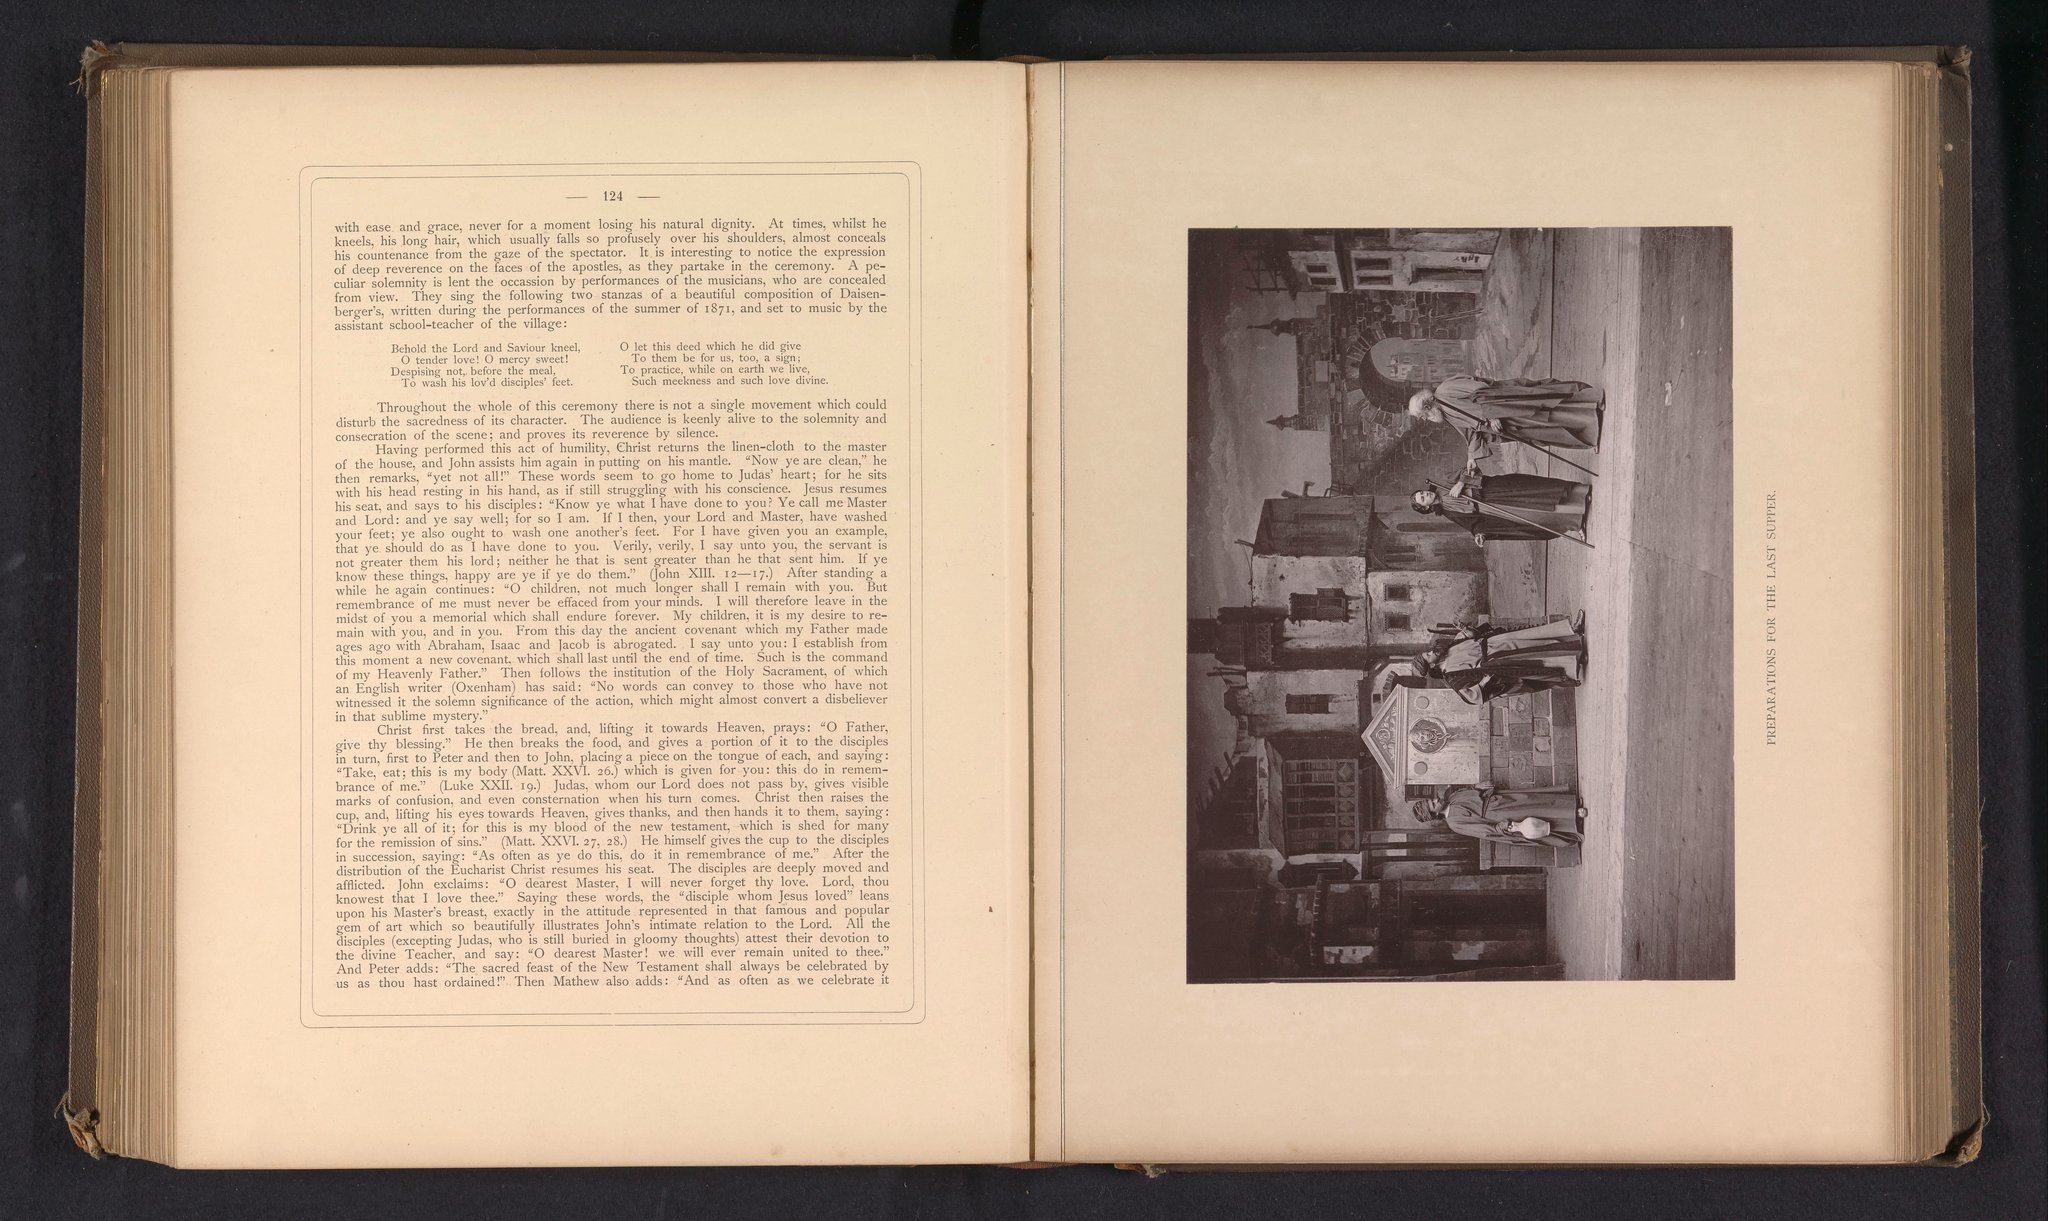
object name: photomechanical print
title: Preparations for the last supper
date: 1885-1890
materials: paper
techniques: photograph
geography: oberammergau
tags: the episode of the last supper, group of actors, troupe; actors on the stage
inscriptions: inscription: ‘Gemeinde Oberammergau Passionsspiel 1890’